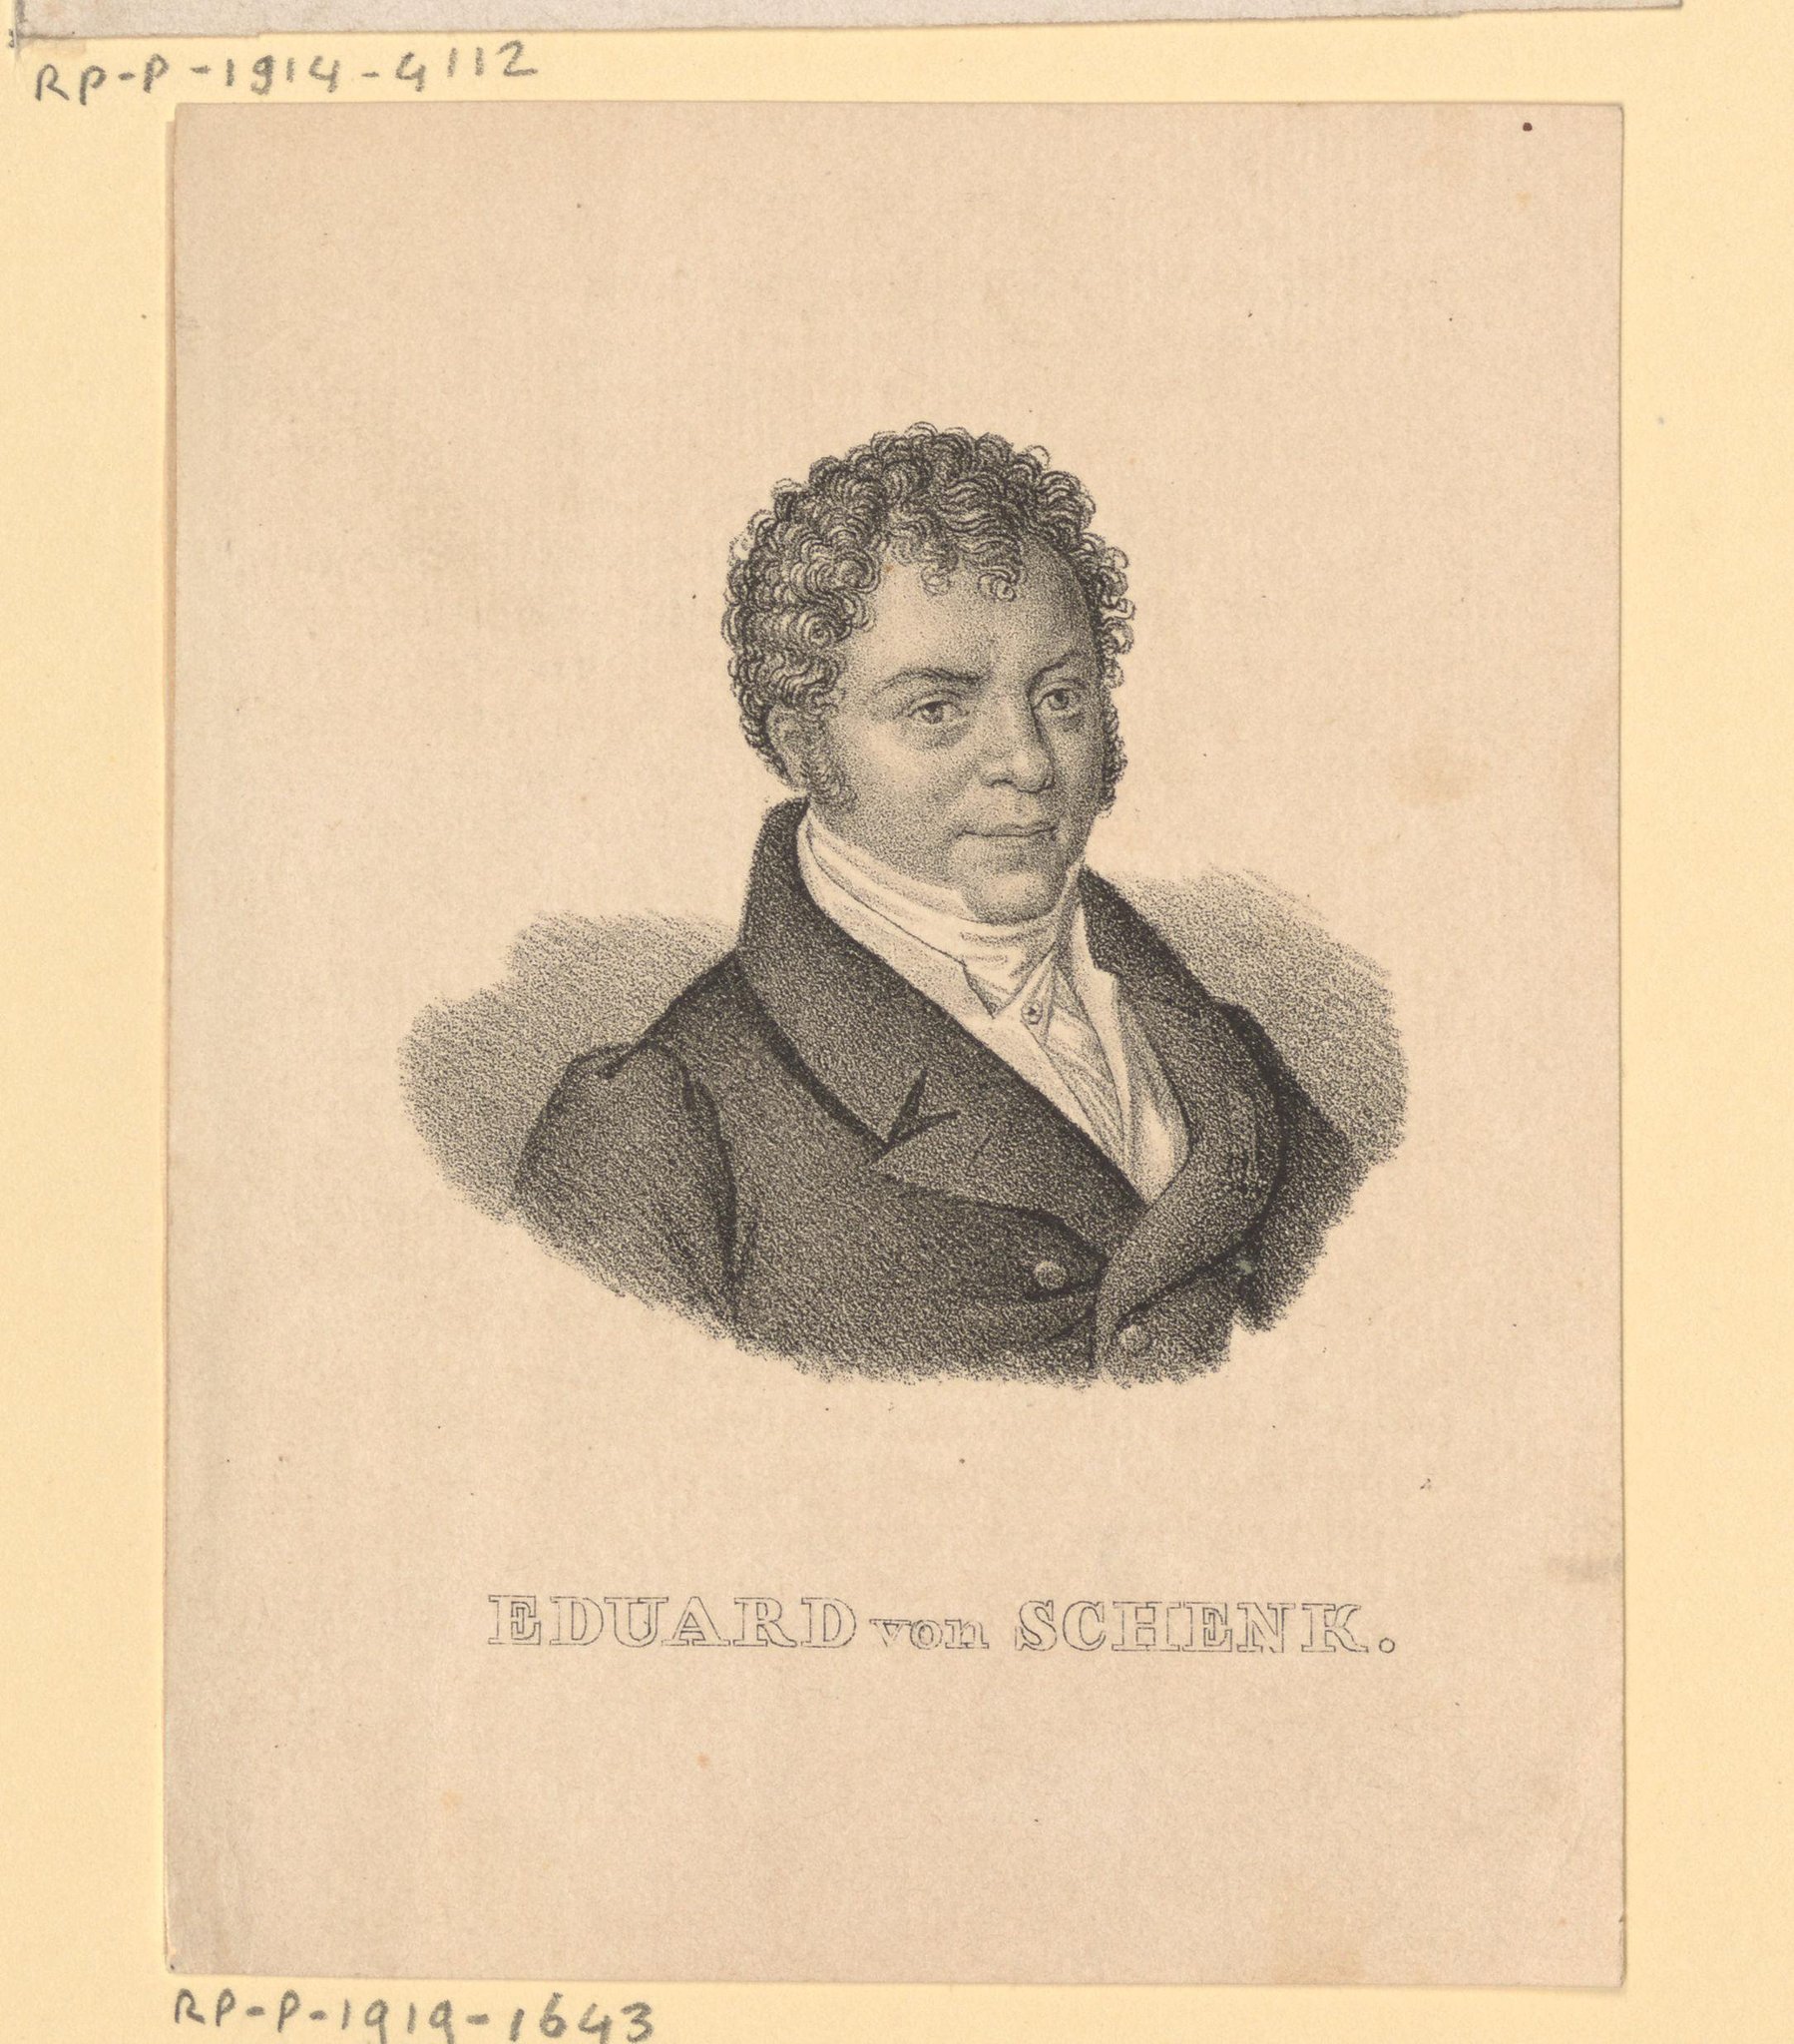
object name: print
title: Portret van Eduard von Schenk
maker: Anonymous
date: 1800-1849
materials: paper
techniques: lithograph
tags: historical persons, writer, poet, author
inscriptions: collector's mark: Lugt 2228